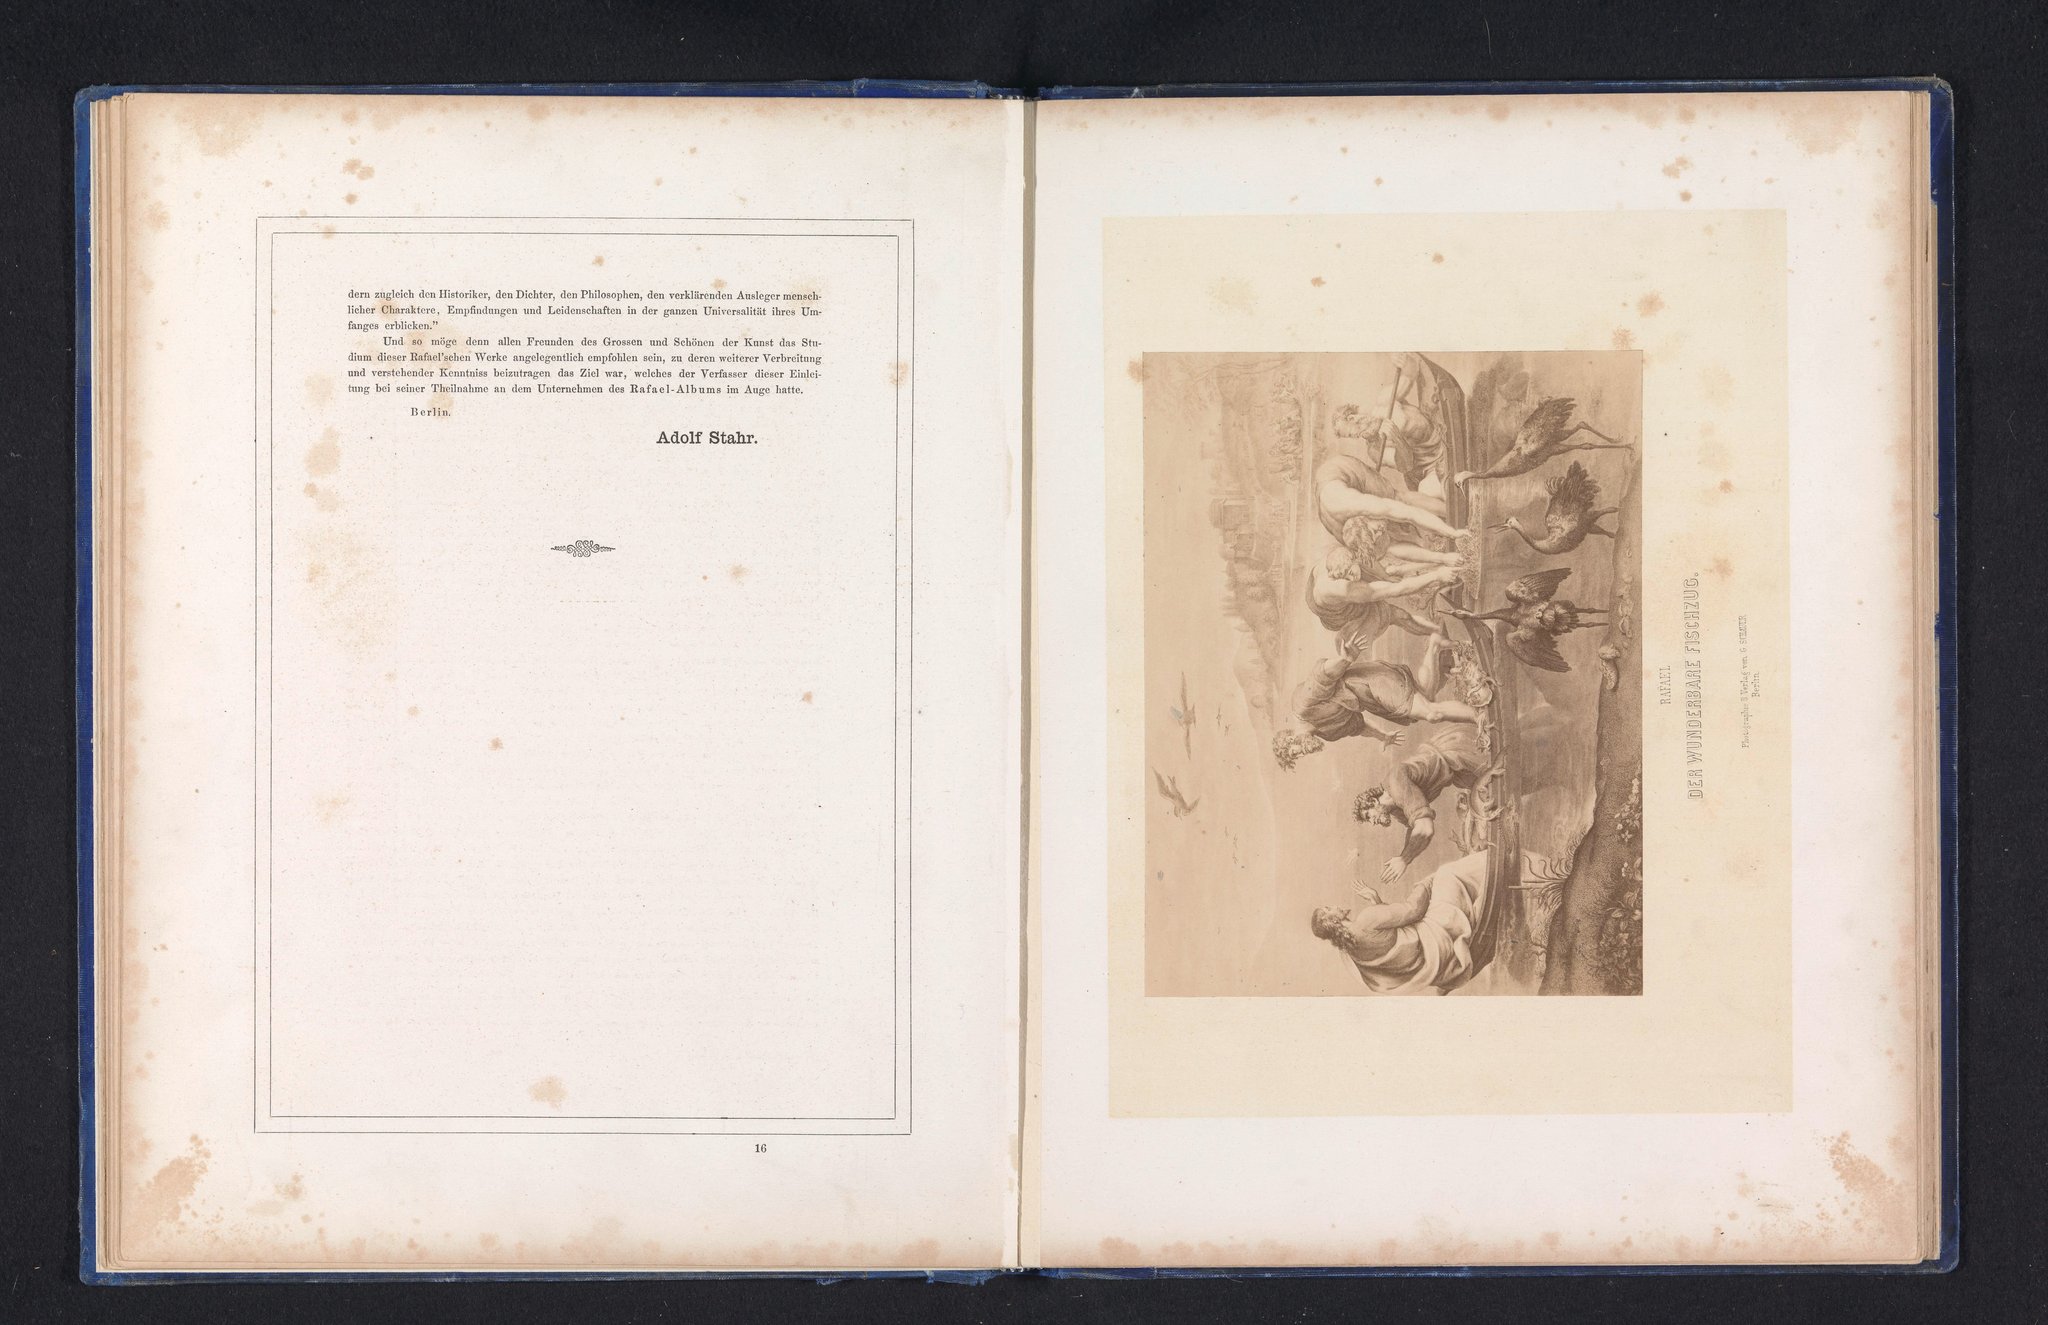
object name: reproduction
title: Fotoreproductie van een prent naar een karton voor een tapijt van de Wonderbare visvangst door Rafaël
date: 1851-1861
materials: photographic support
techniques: albumen print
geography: berlin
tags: the miraculous draught of fishes (before the resurrection) on the lake of gennesaret (sea of galilee); james and john helping to bring in the nets (luke 5:1-11)